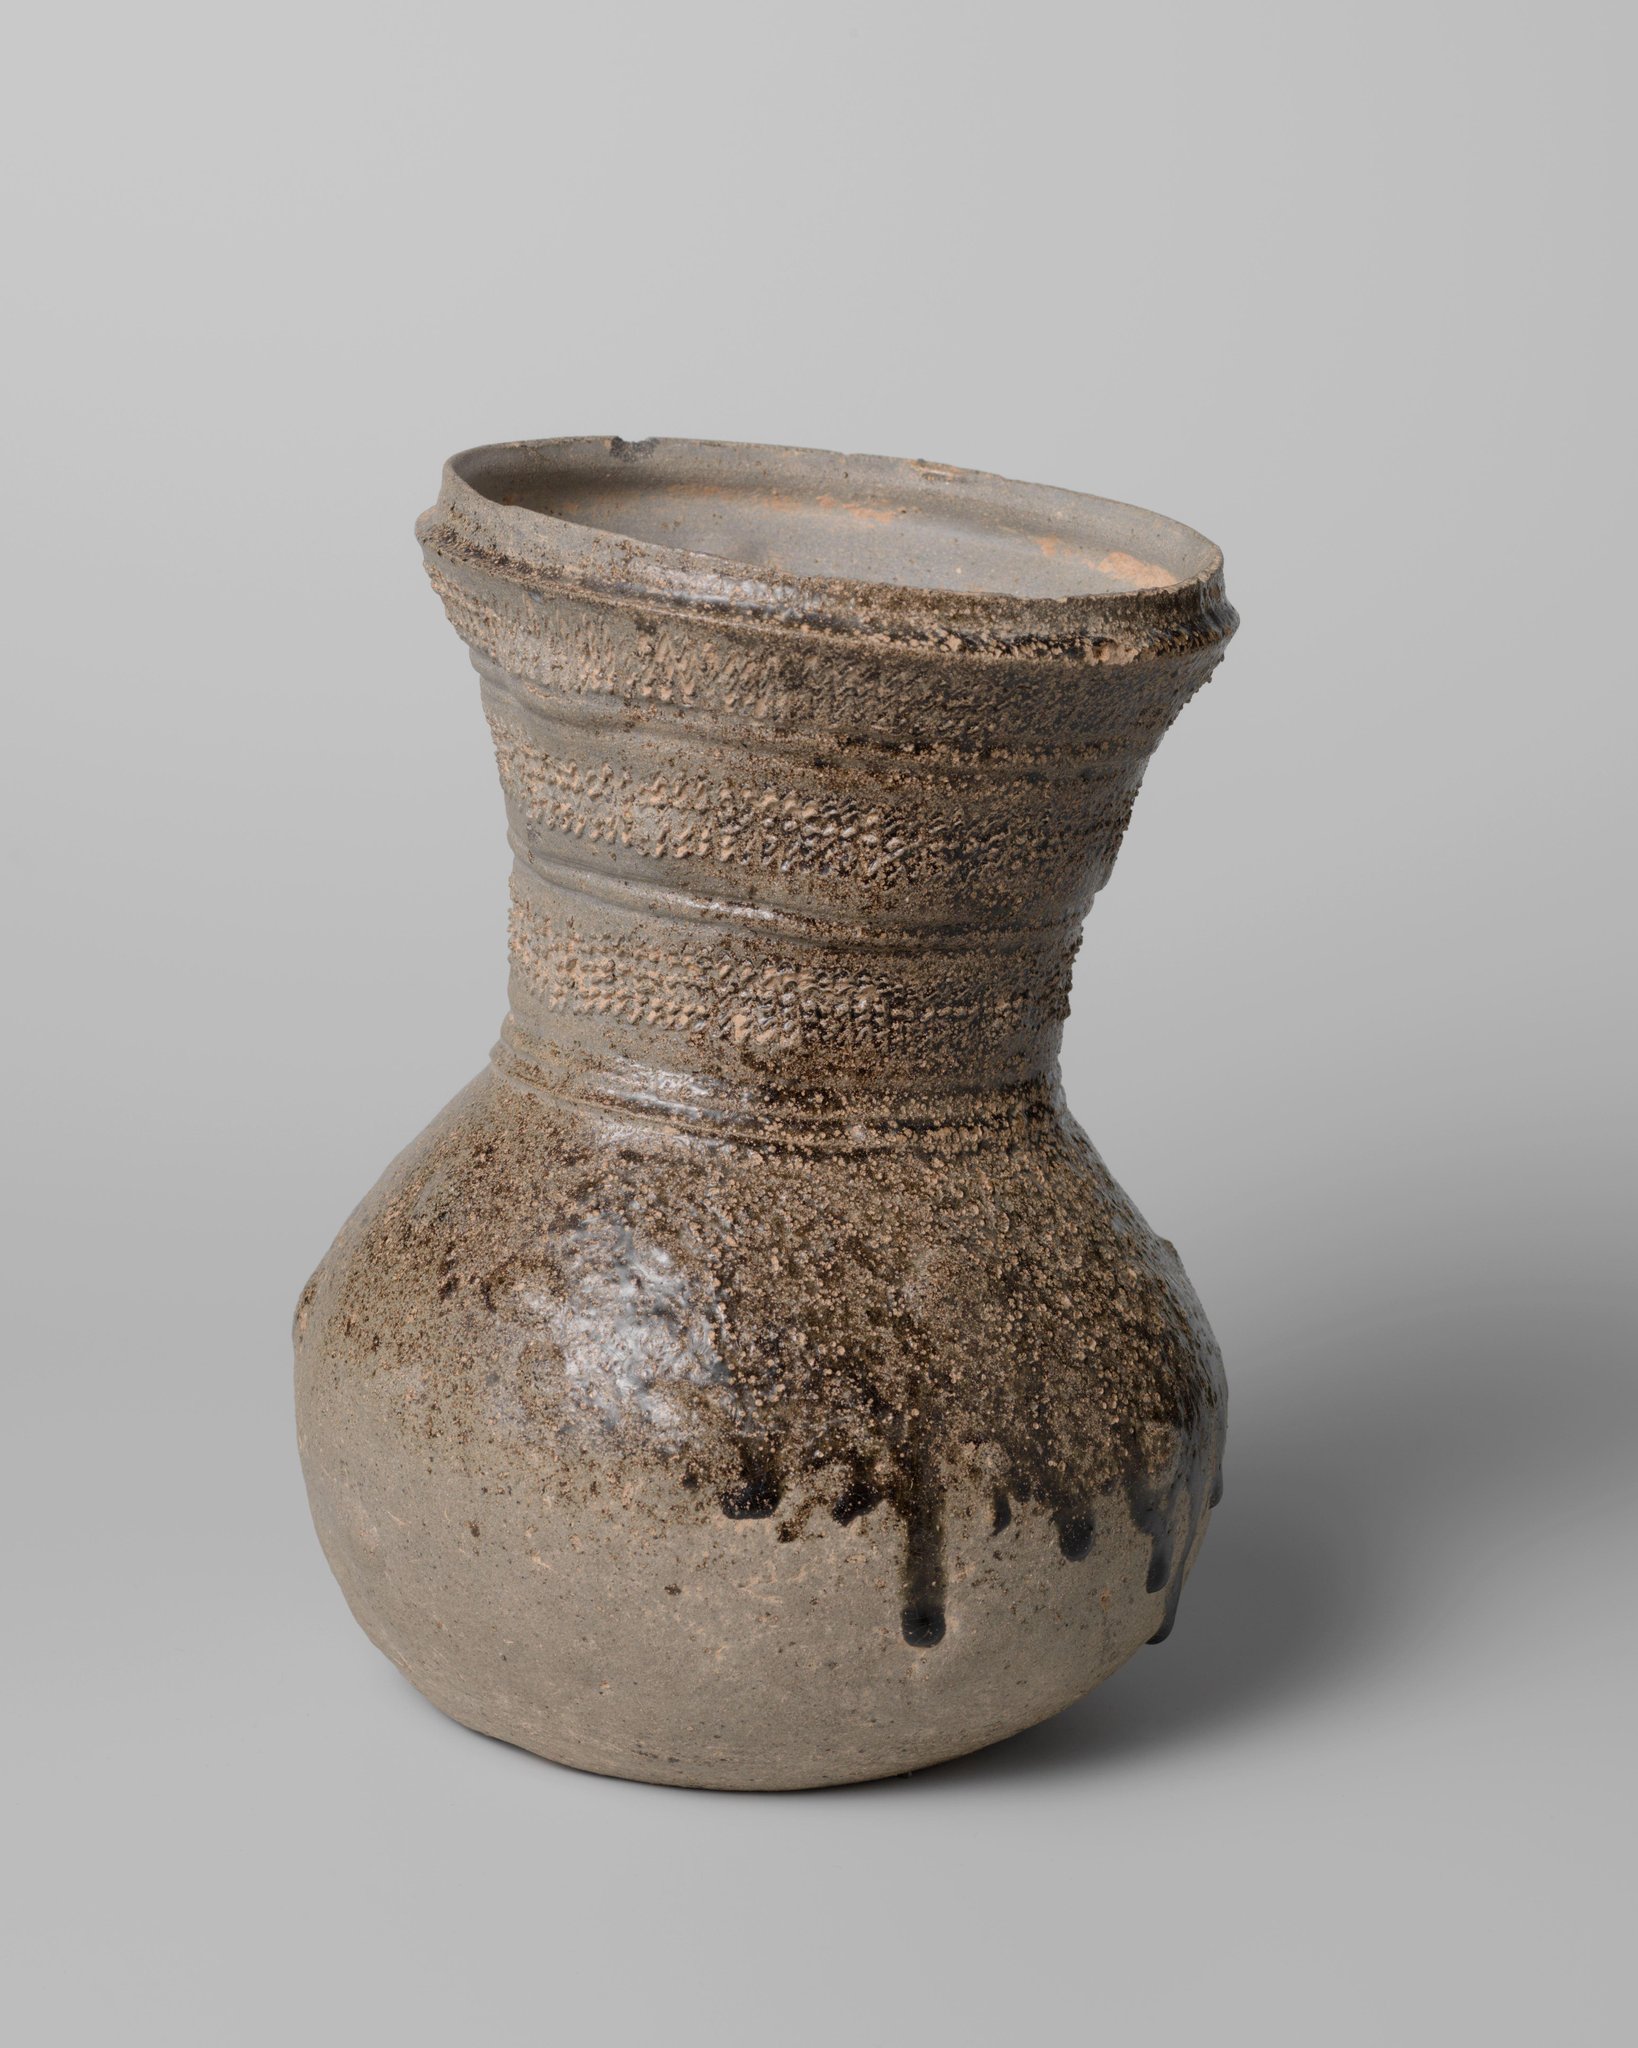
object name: pot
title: Jar with a dark green glaze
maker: Anonymous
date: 400-599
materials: glaze, stoneware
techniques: firing, turning, vitrification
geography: korea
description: Pot van steengoed met een bolvormig lichaam, uitlopende nek en opstaande rand, gedeeltelijk bedekt met een donkergroen glazuur. Op de nek drie ingegrifte banden.